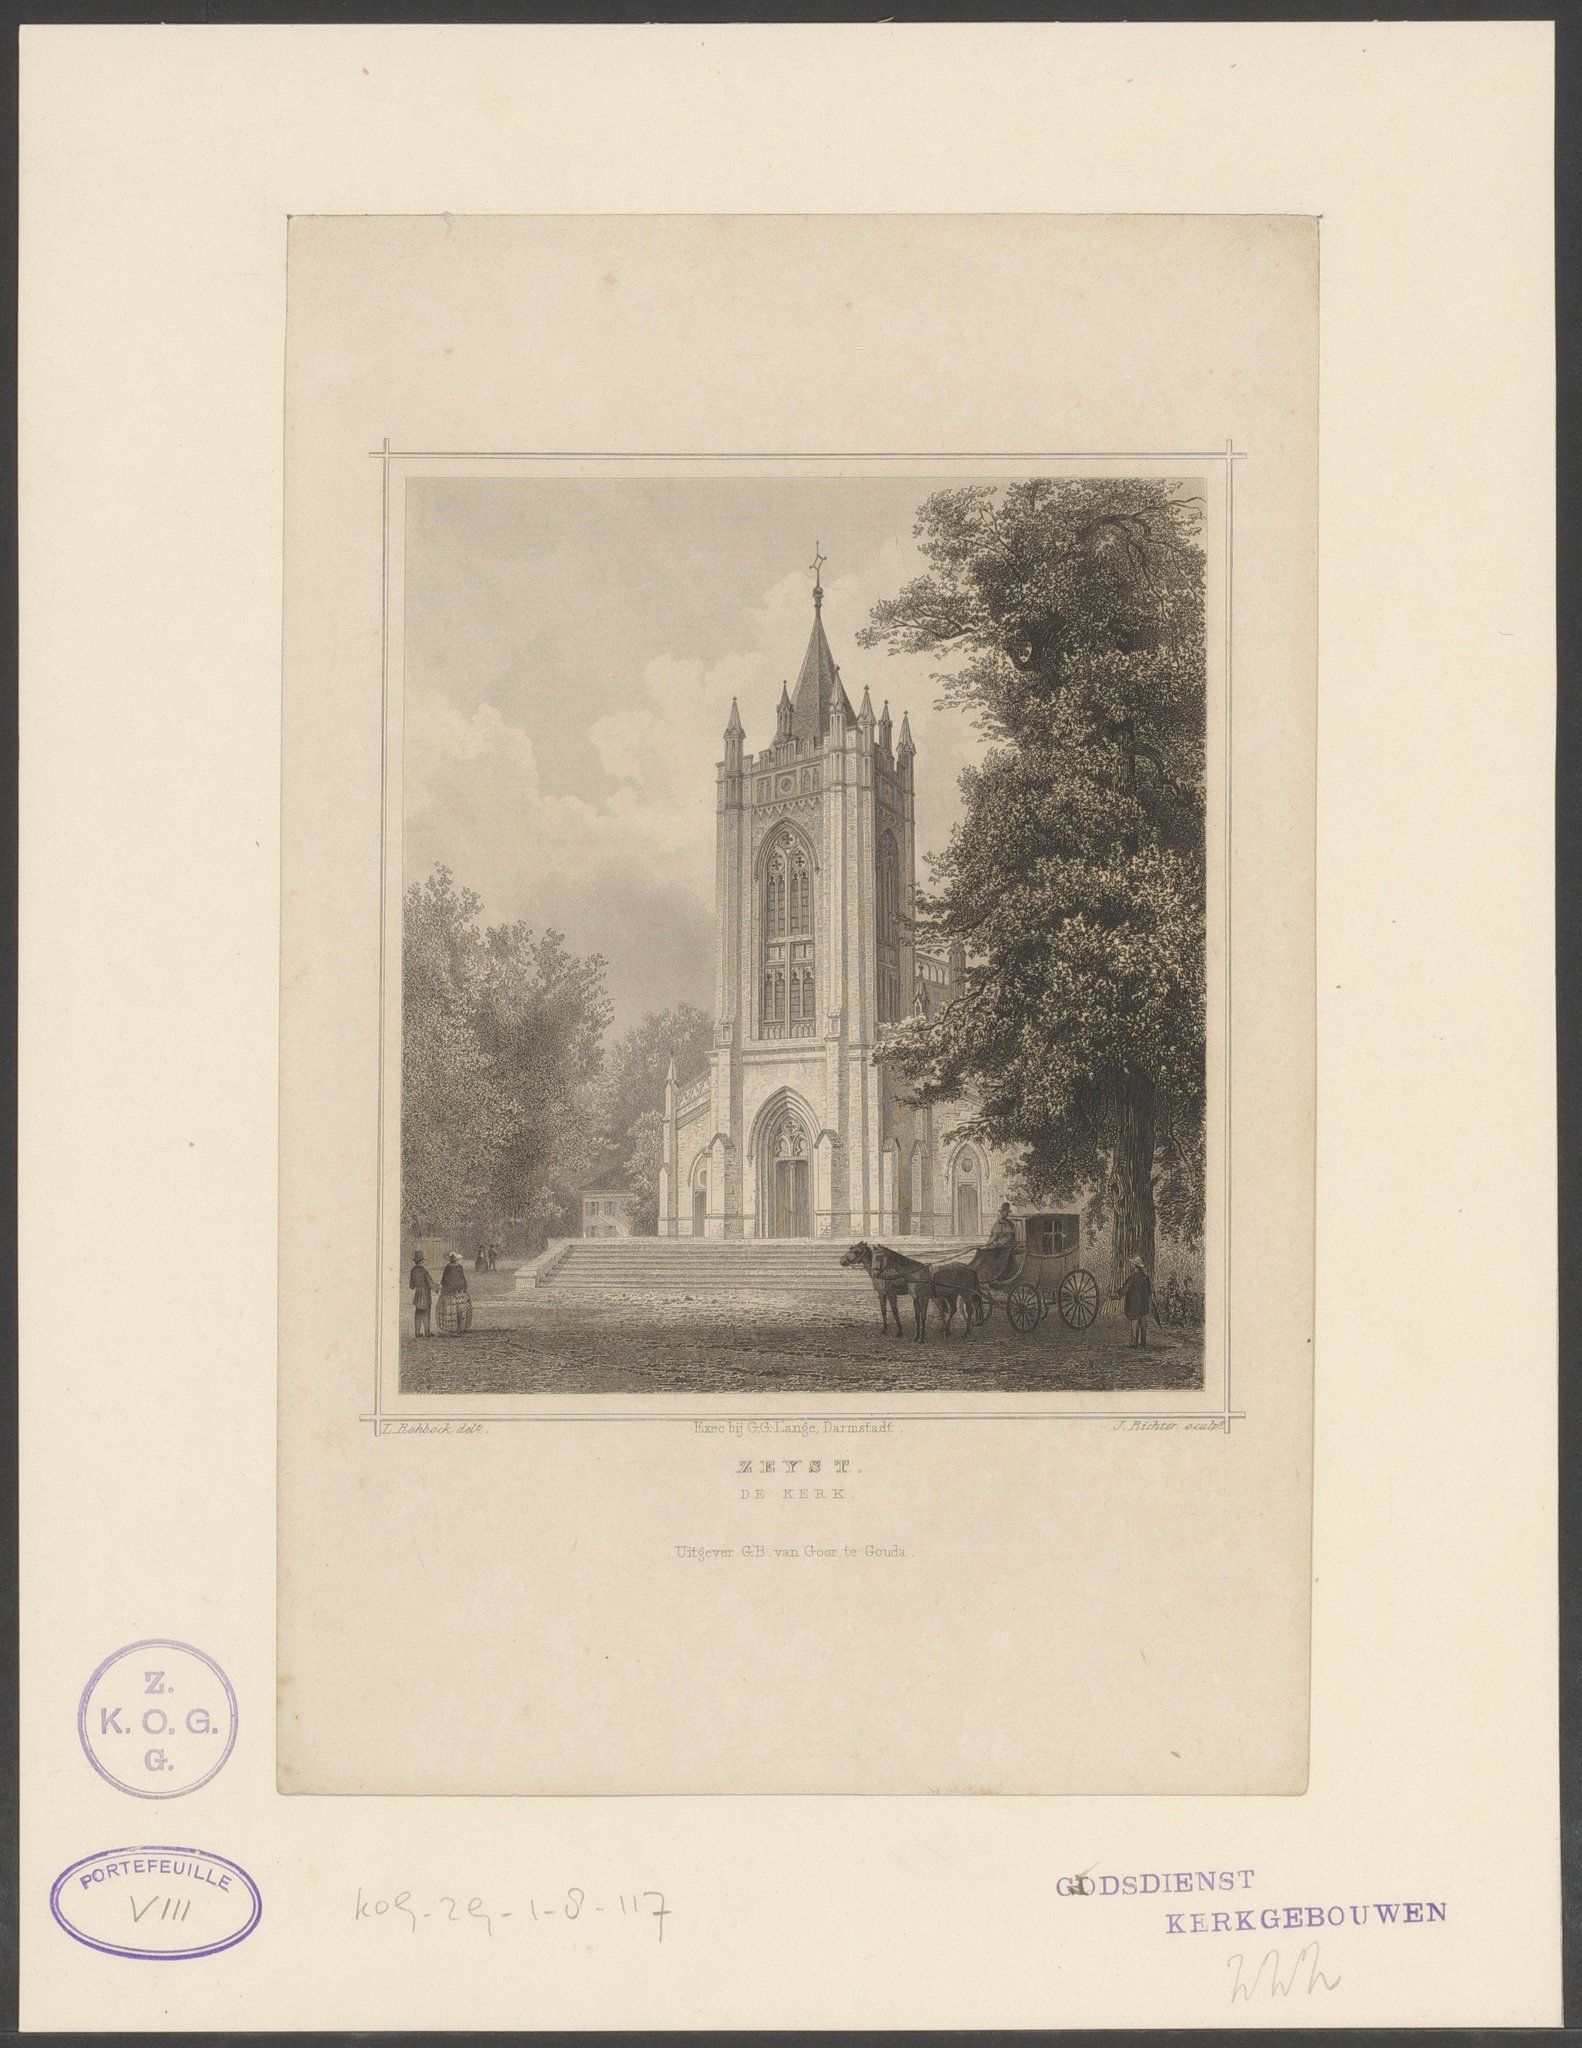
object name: print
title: Zeyst. De Kerk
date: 1855-1857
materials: paper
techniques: engraving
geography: darmstadt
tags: church (exterior)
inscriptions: collector's mark: Lugt 1641, collector's mark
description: Prent uit: Terwen, J.L. Het koningrijk der Nederlanden (...). 2 dln. Gouda: G.B. van Goor, 1857. Dezelfde prent, met een ander onderschrift, komt ook voor in: Der Rhein und die Rheinlande in malerischen Original-ansichten. 3 dln. Darmstadt: G.G. Lange, 1863.